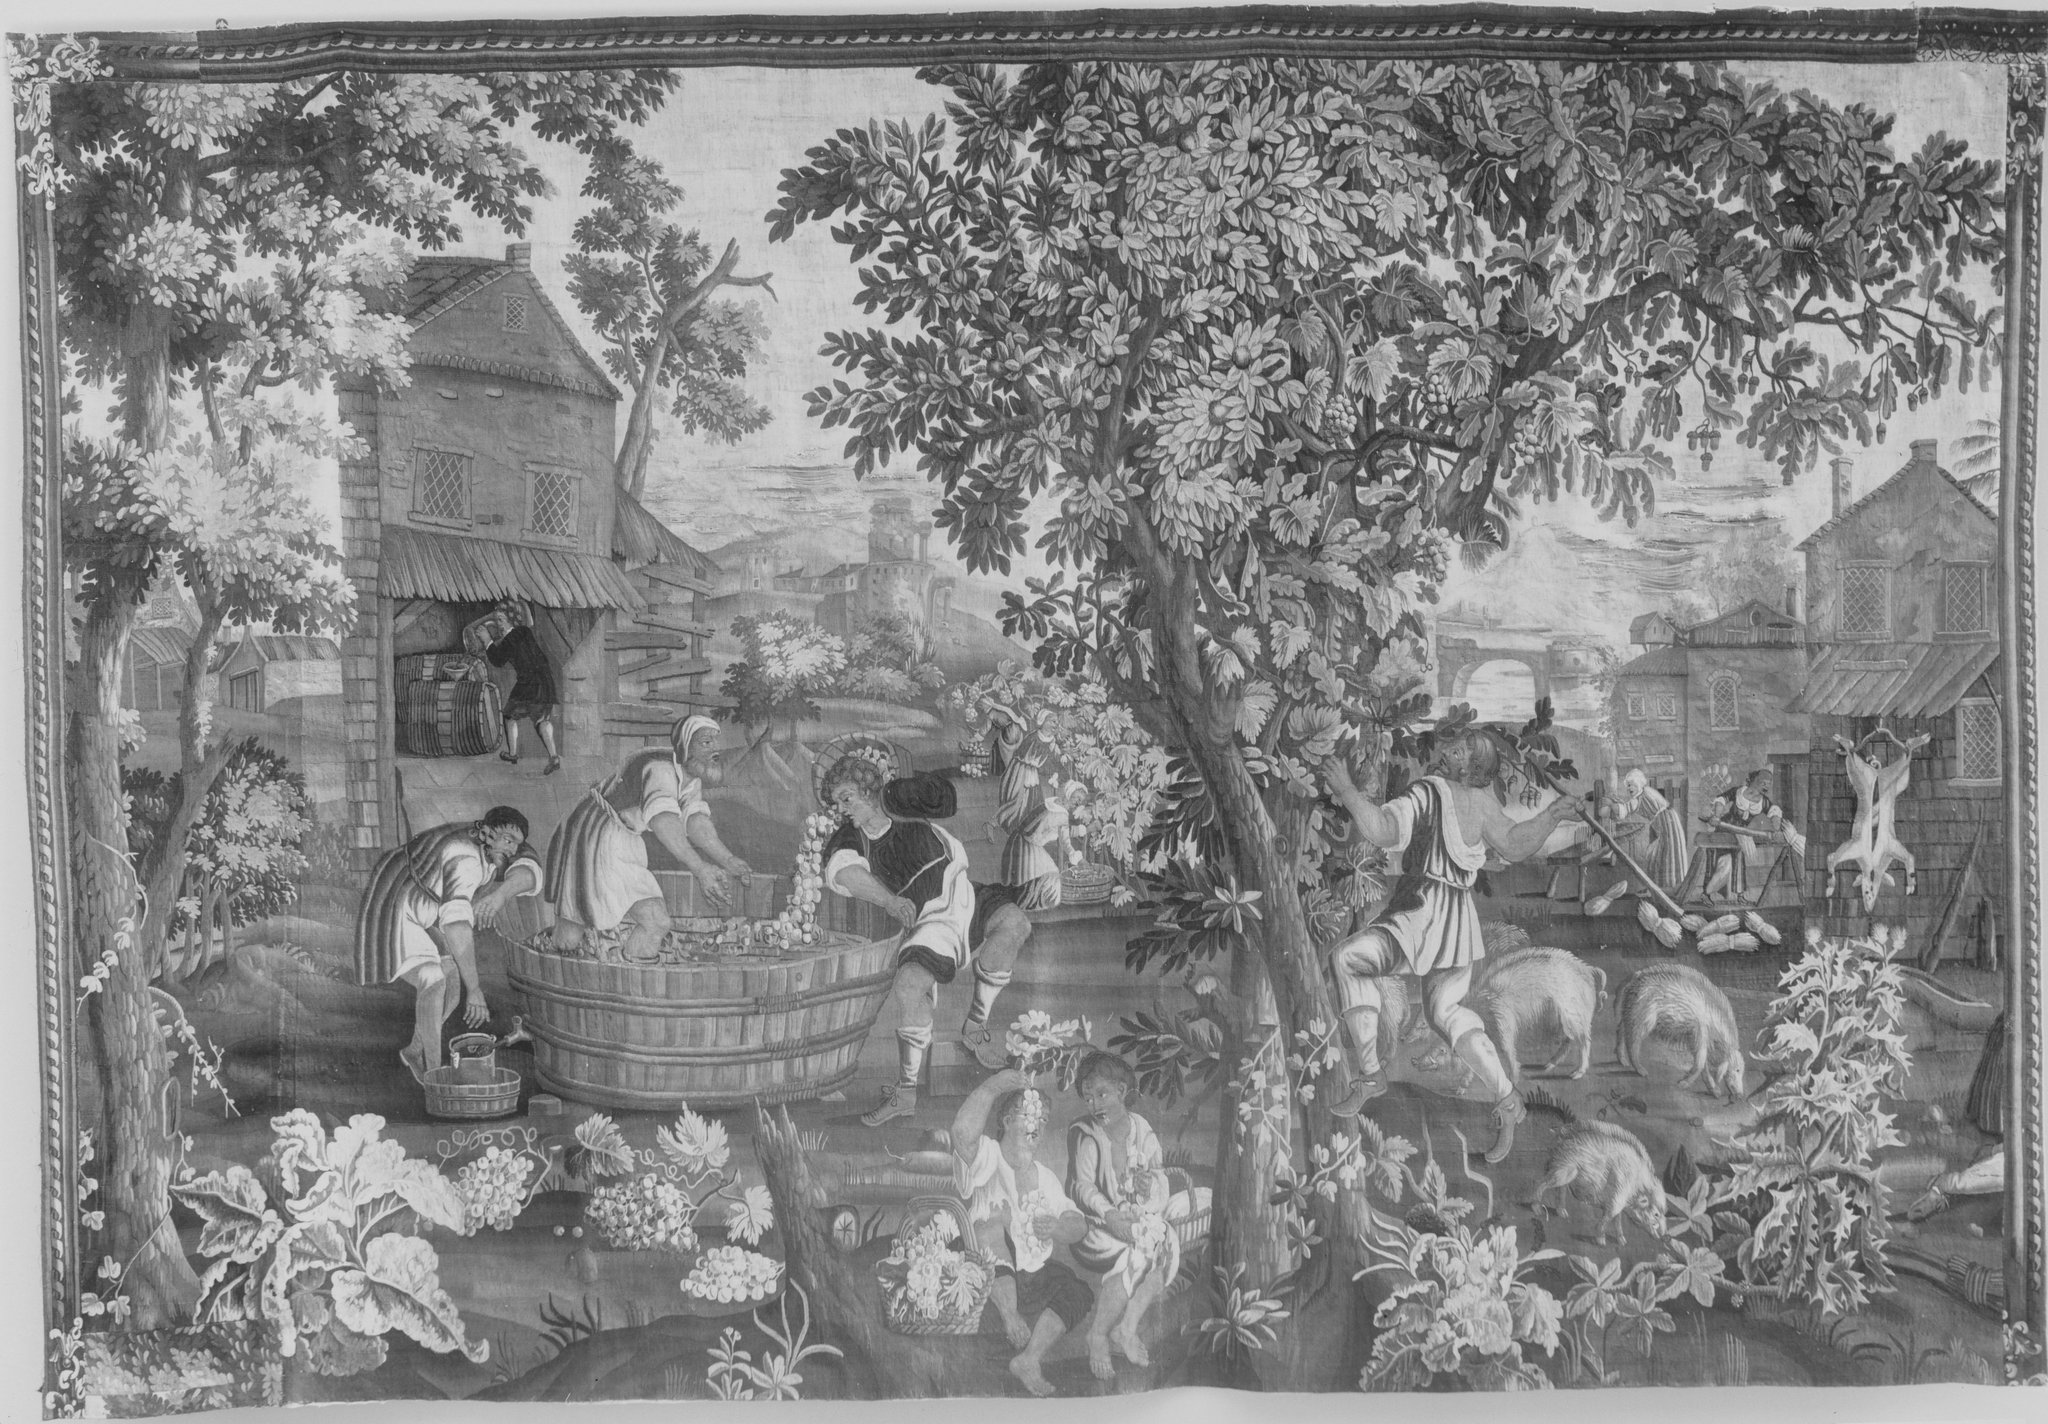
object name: tapestry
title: Autumn from a set of The Seasons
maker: john chabanex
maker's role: maker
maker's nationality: french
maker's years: 1696-1744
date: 1701-1733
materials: silk, wool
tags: grapes,children,men,women,pigs,autumn